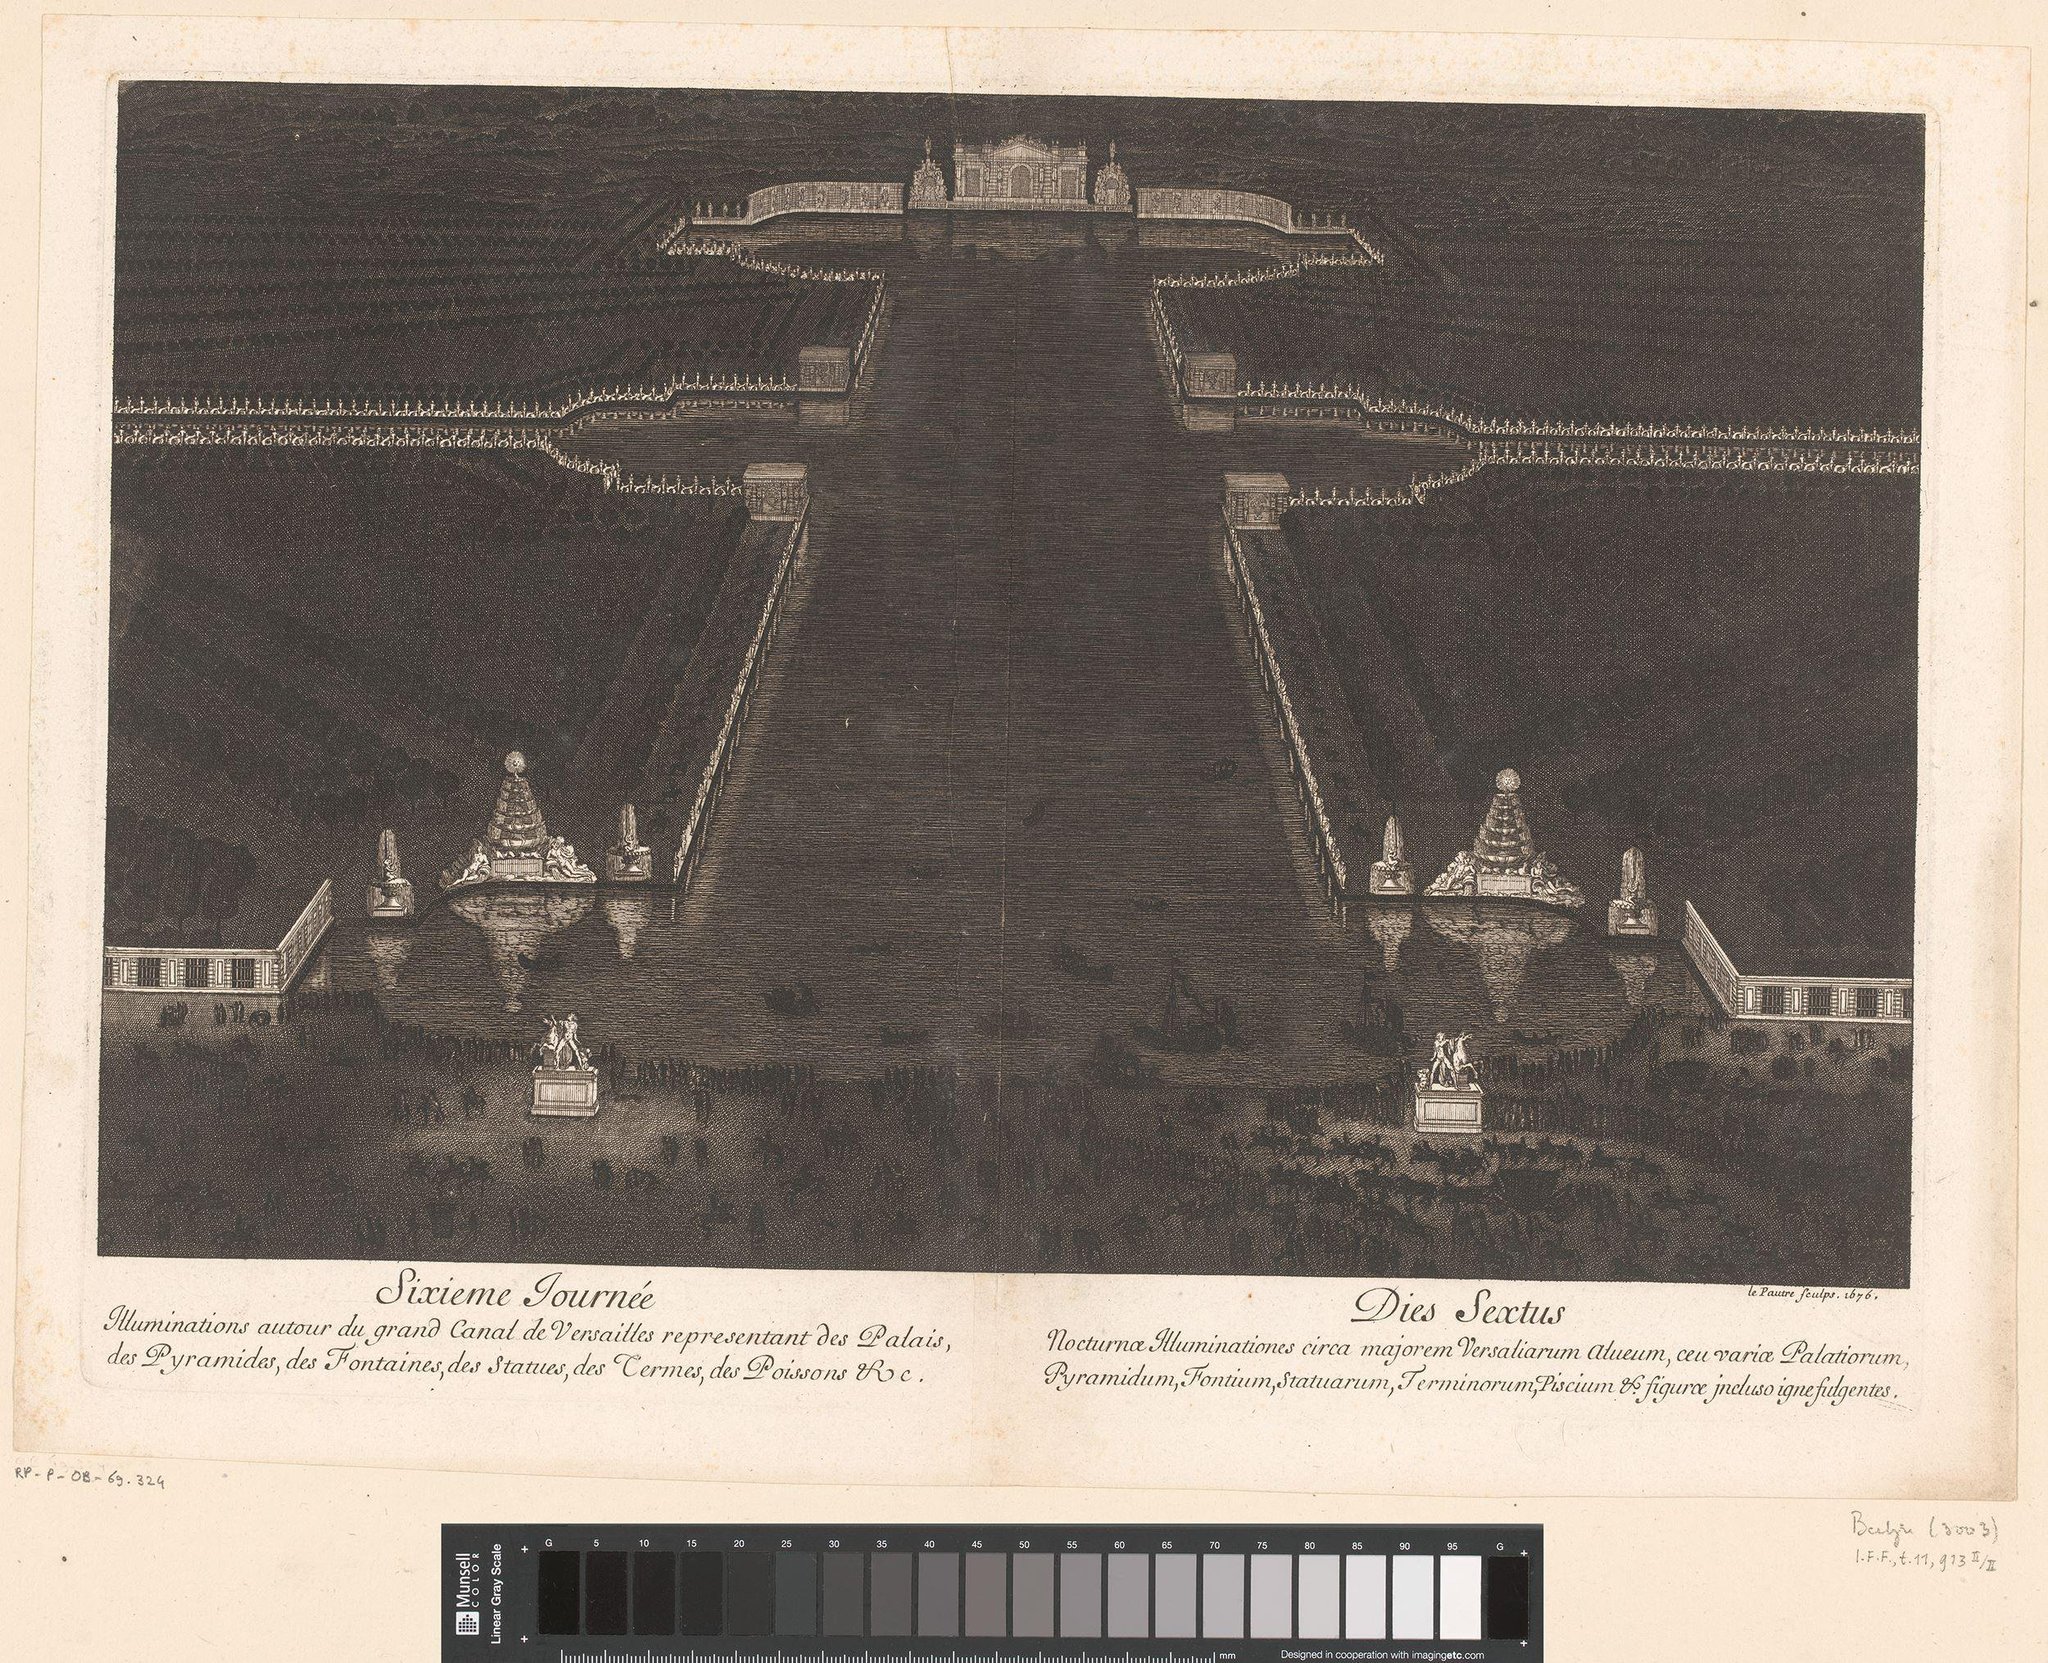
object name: print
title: Sixieme Journée. Illuminations autour du grand Canal de Versailles representant des Palais, des Pyramides, des Fontaines, des statues, es Termes, des Poissons & c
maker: jean lepautre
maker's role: draughtsman, print maker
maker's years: 1618-1682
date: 1676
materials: paper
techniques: engraving, etching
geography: paris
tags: lodewijk xiv (koning van frankrijk), garden fountain, french or architectonic garden; formal garden, water-works in garden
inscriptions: collector's mark: Lugt 240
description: Maakt deel uit van een vijfdelige serie met voorstellingen van de festiviteiten die door Lodewijk XIV in Versailles gehouden werden na de verovering van Franche-Comté in 1674. De serie bestaat uit prenten door verschillende kunstenaars, werd voorzien van tekst door André Félibien en werd uitgegeven in 1676 door de Imprimerie Royale te Parijs. De serie werd opgenomen in 'Cabinet du Roy', dl. 11. Zie IFF 17e siècle, p. 318 en British Museum inv.nr. 1889,1218.145.